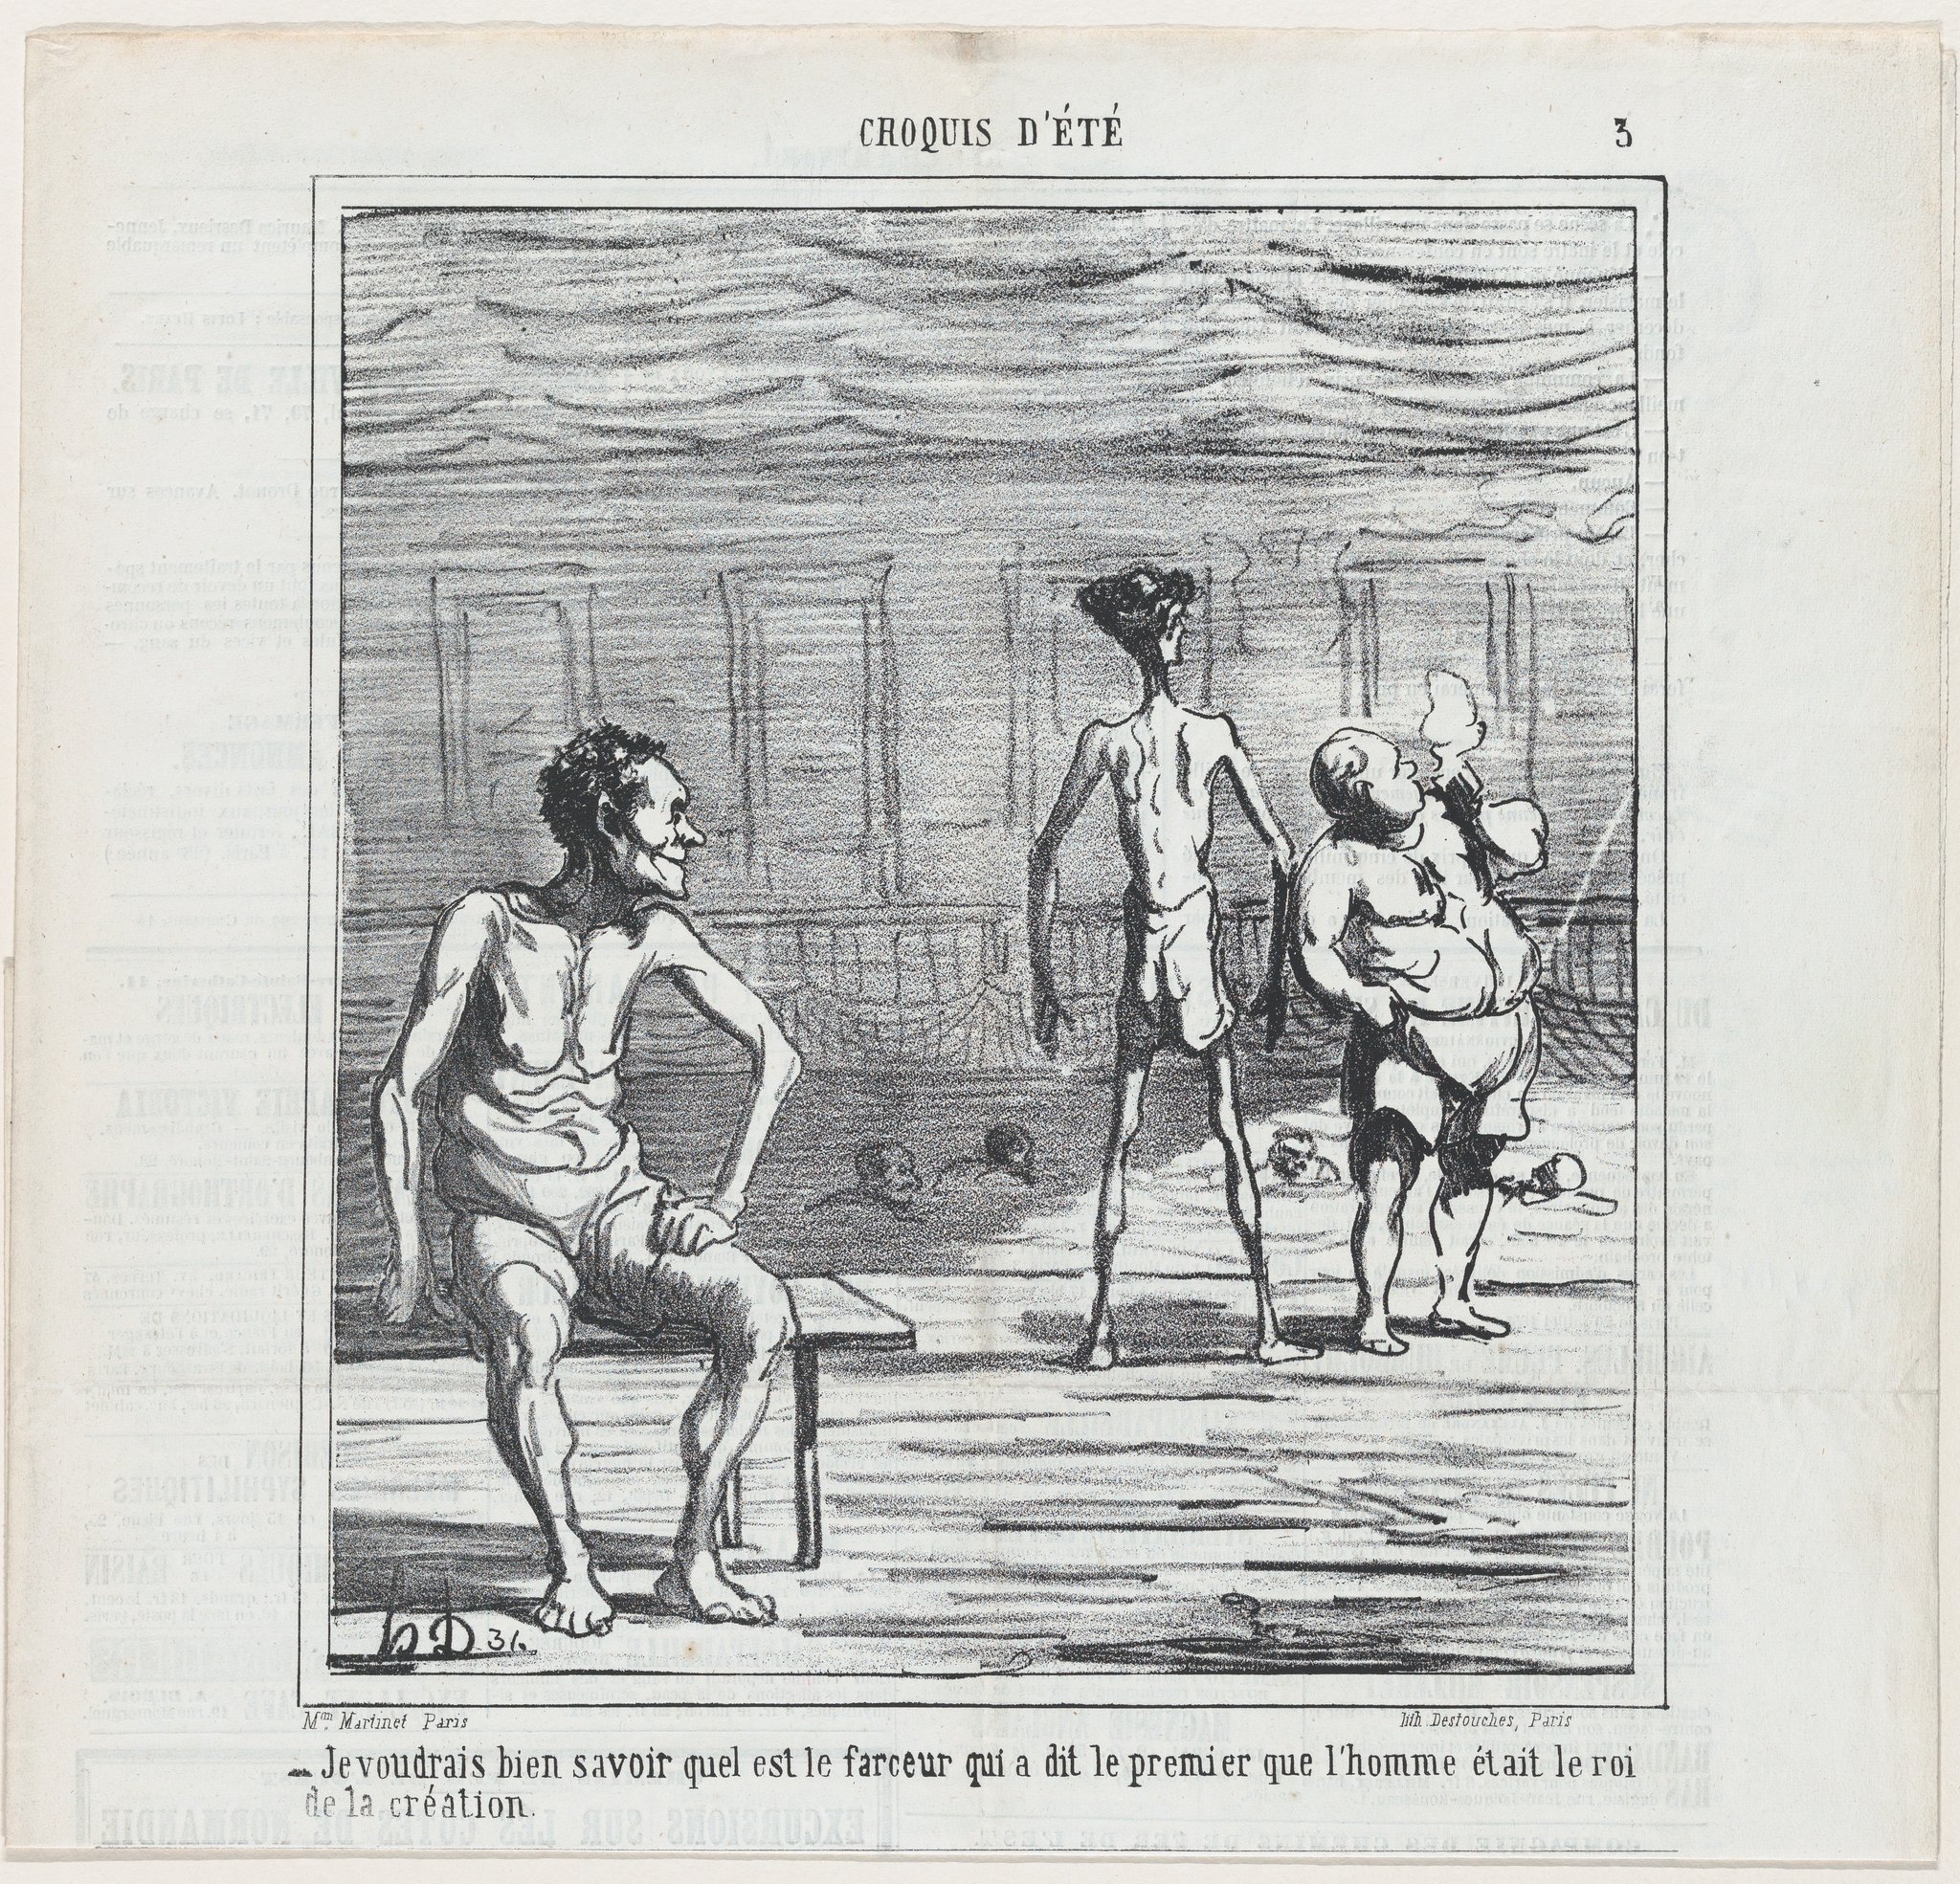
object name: print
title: I'm just wondering who might have been the joker who insisted that man was at the pinnacle of creation, from "Summer sketches"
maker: honoré daumier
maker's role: artist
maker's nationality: french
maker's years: 1808-1879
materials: paper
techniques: lithograph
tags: men,swimming